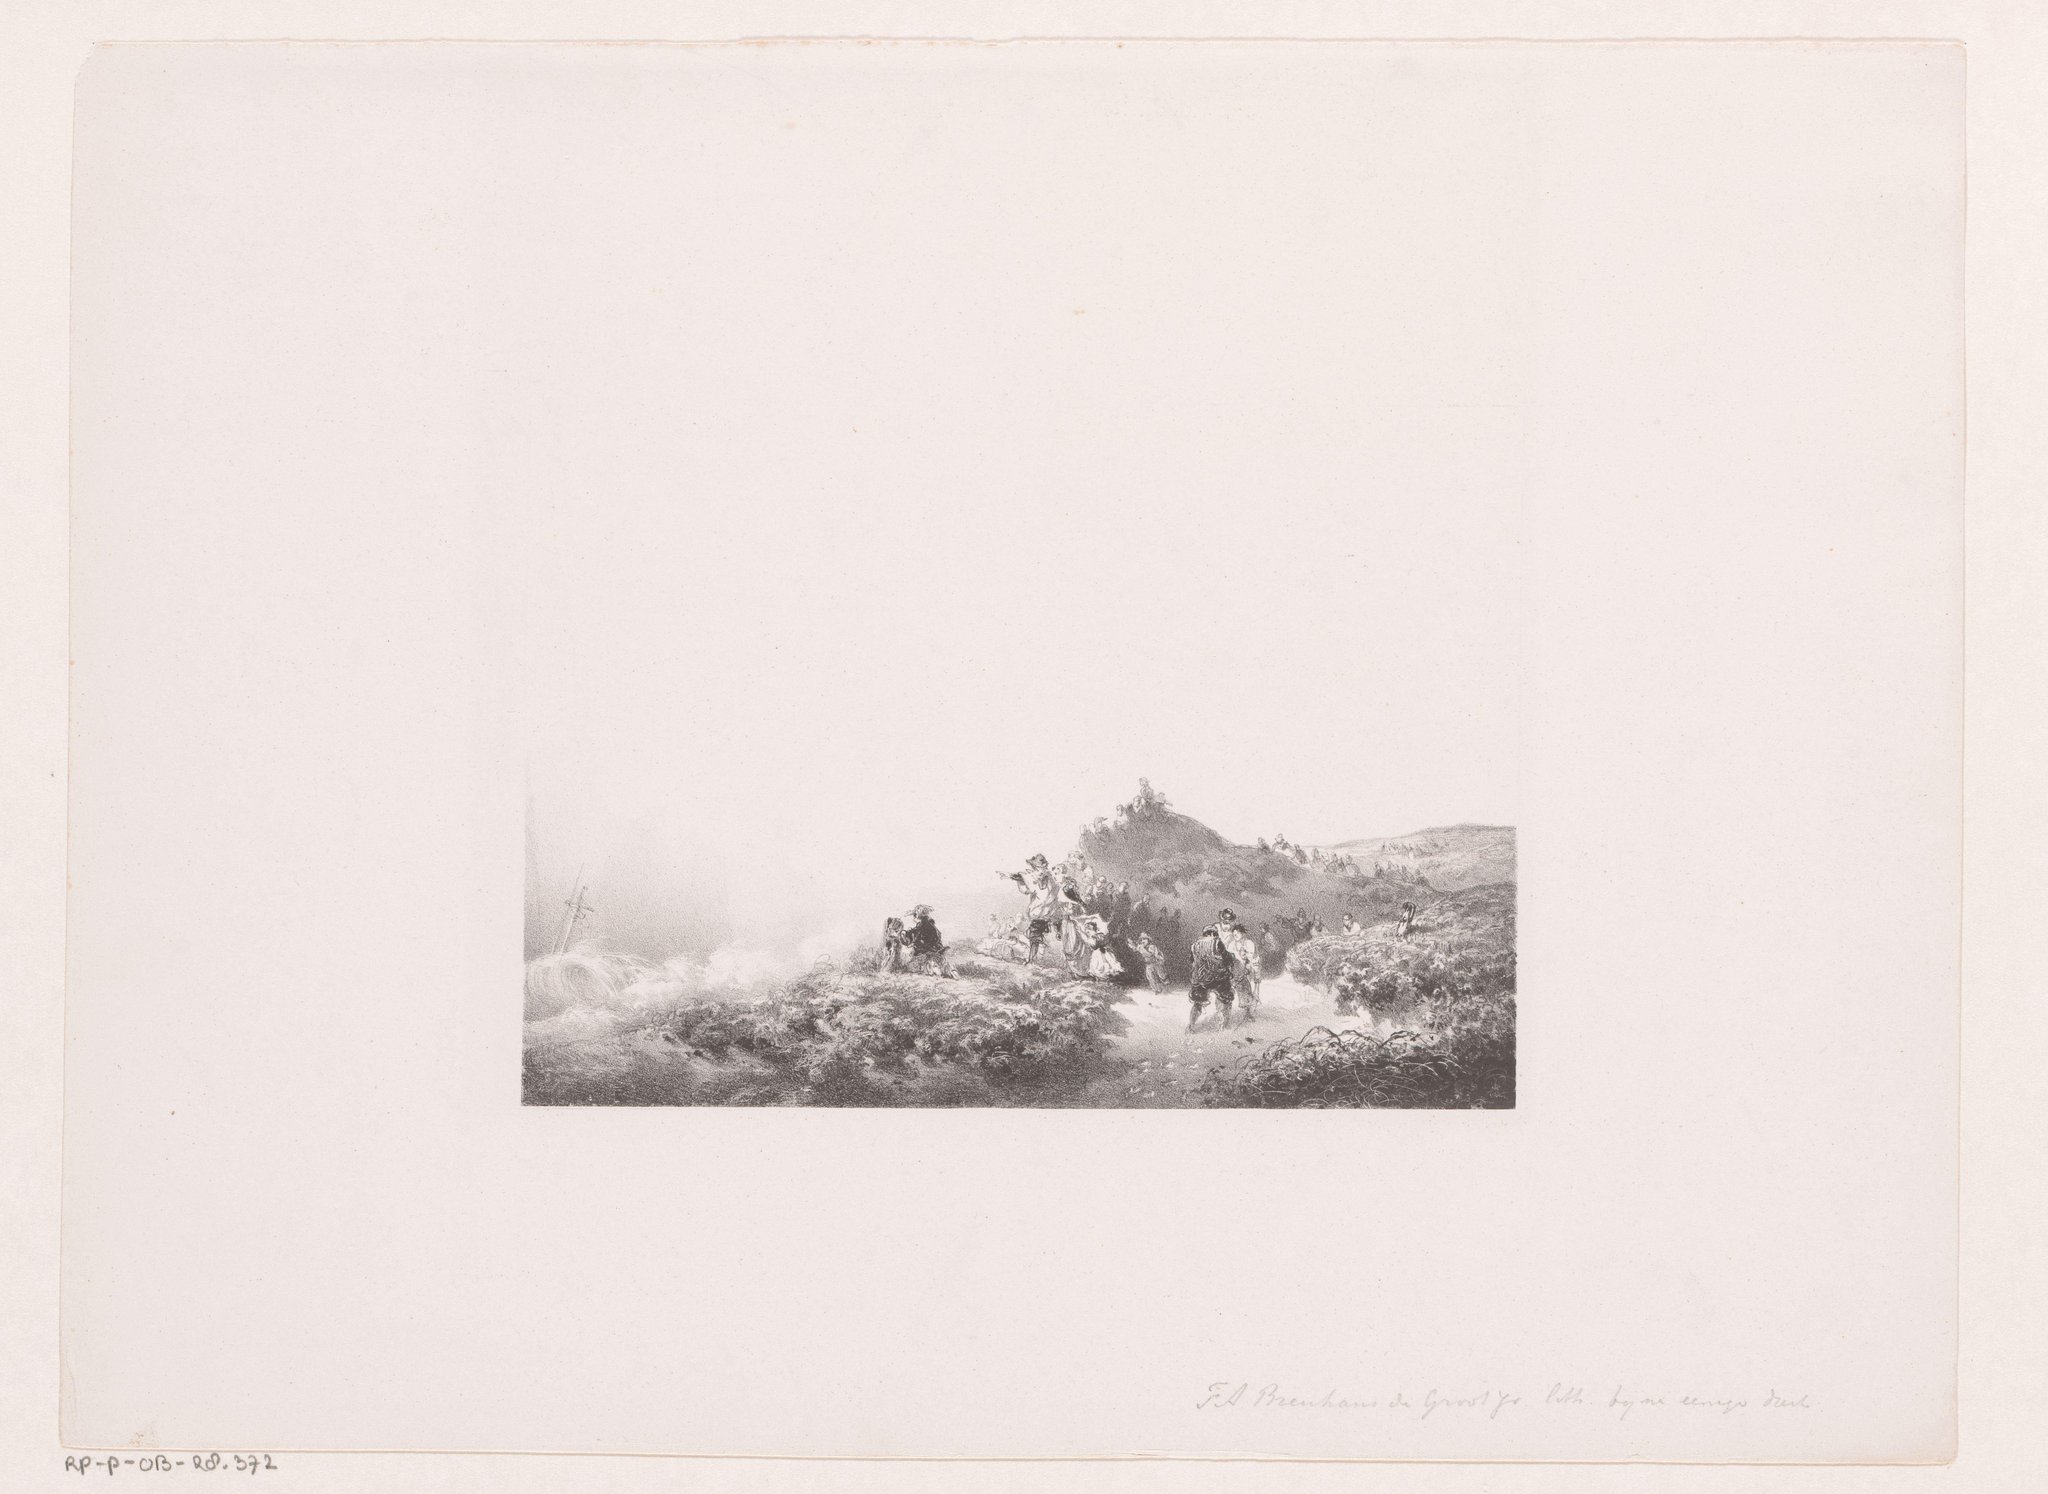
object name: print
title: Mensen in de duinen kijken naar een schip in nood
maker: frans arnold breuhaus de groot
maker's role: draughtsman, print maker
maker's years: 1824-1872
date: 1834-1872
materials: paper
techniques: lithograph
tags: shipwreck, dune coast (+ landscape with figures, staffage)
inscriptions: inscription: ‘F A Breuhaus de Groot Jr. lith bijna eenige druk’, collector's mark: Lugt 2228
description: In het water is nog net de mast van het schip zichtbaar.